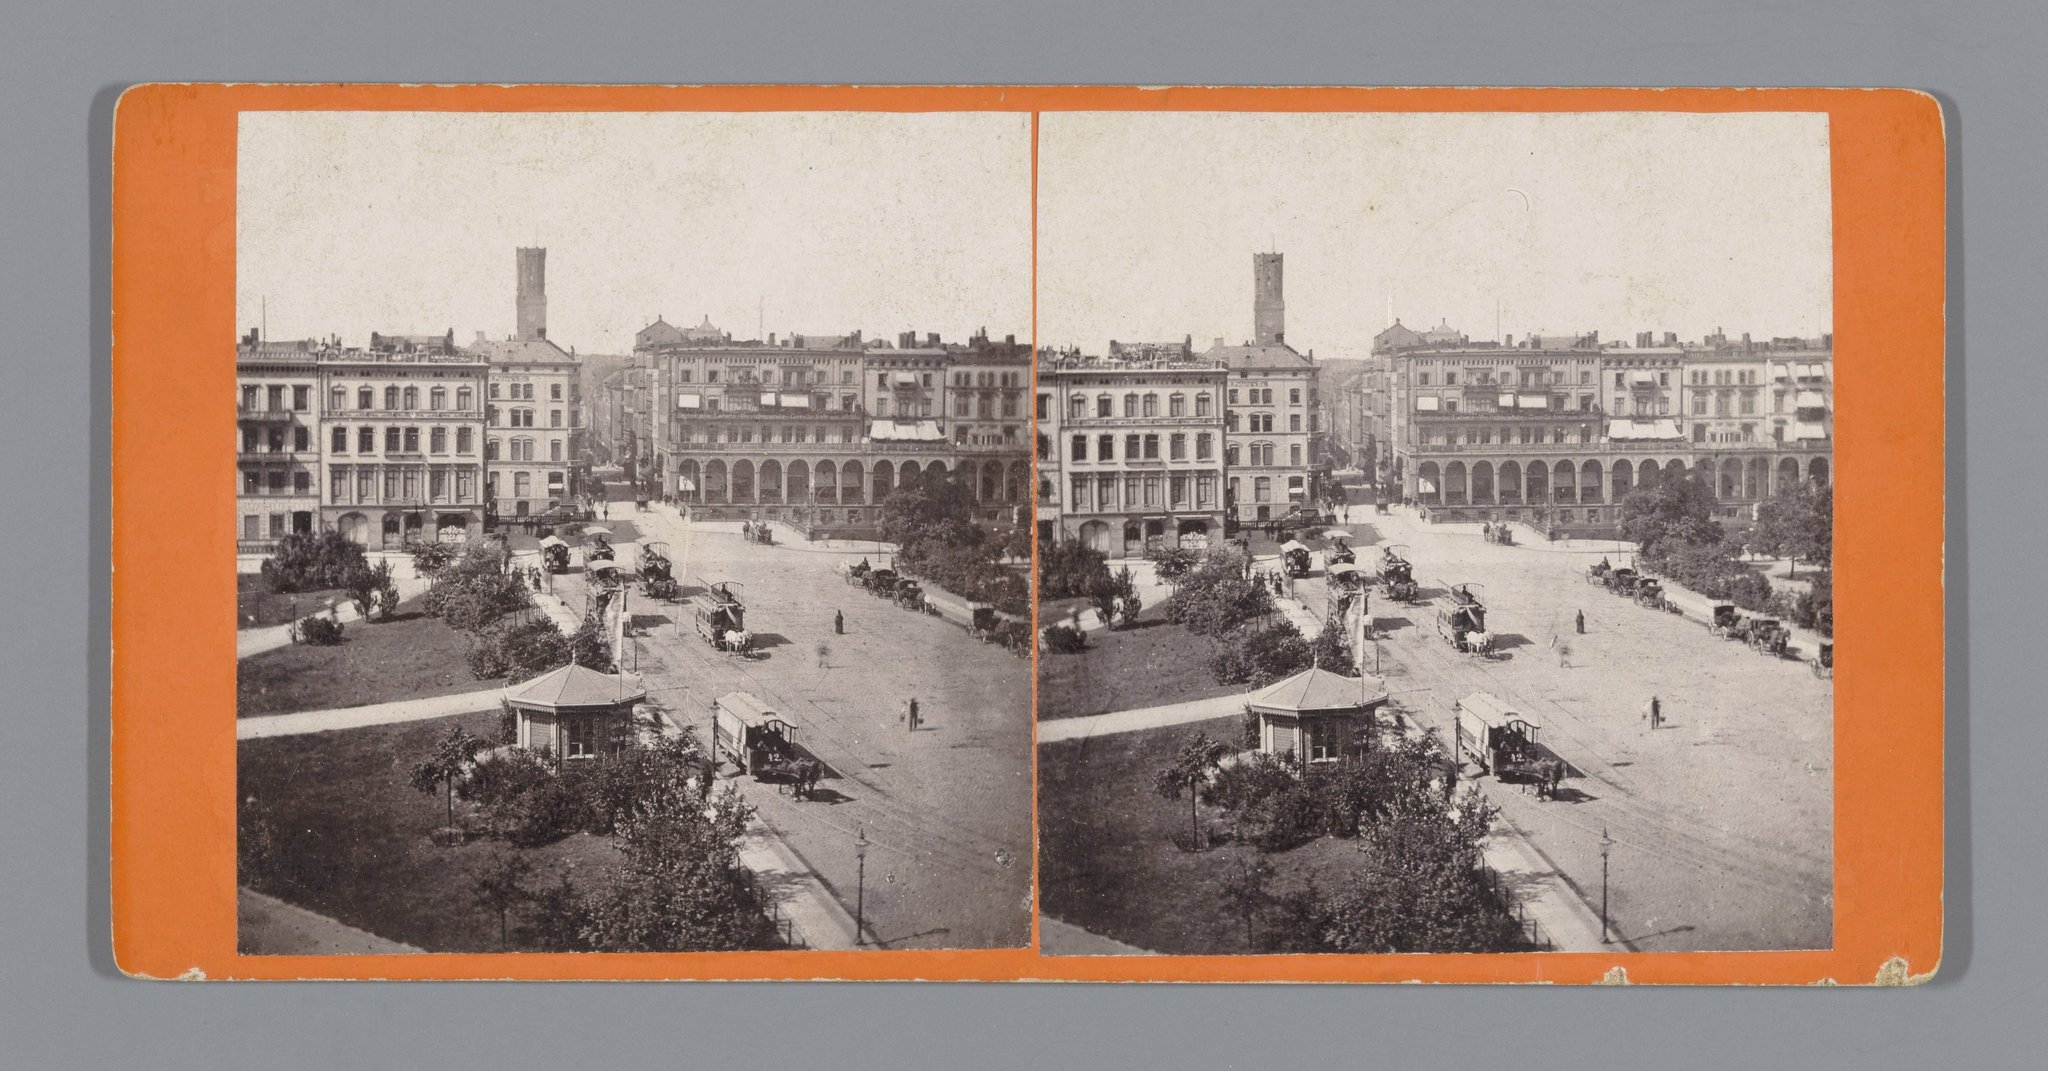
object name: stereograph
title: Gezicht op de Rathausmarkt te Hamburg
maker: Anonymous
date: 1860-1885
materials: cardboard, photographic support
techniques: albumen print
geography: hamburg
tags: square, place, circus, etc., city-view in general; 'veduta'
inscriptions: inscription: ‘Hamburg Rathhausmarkt’